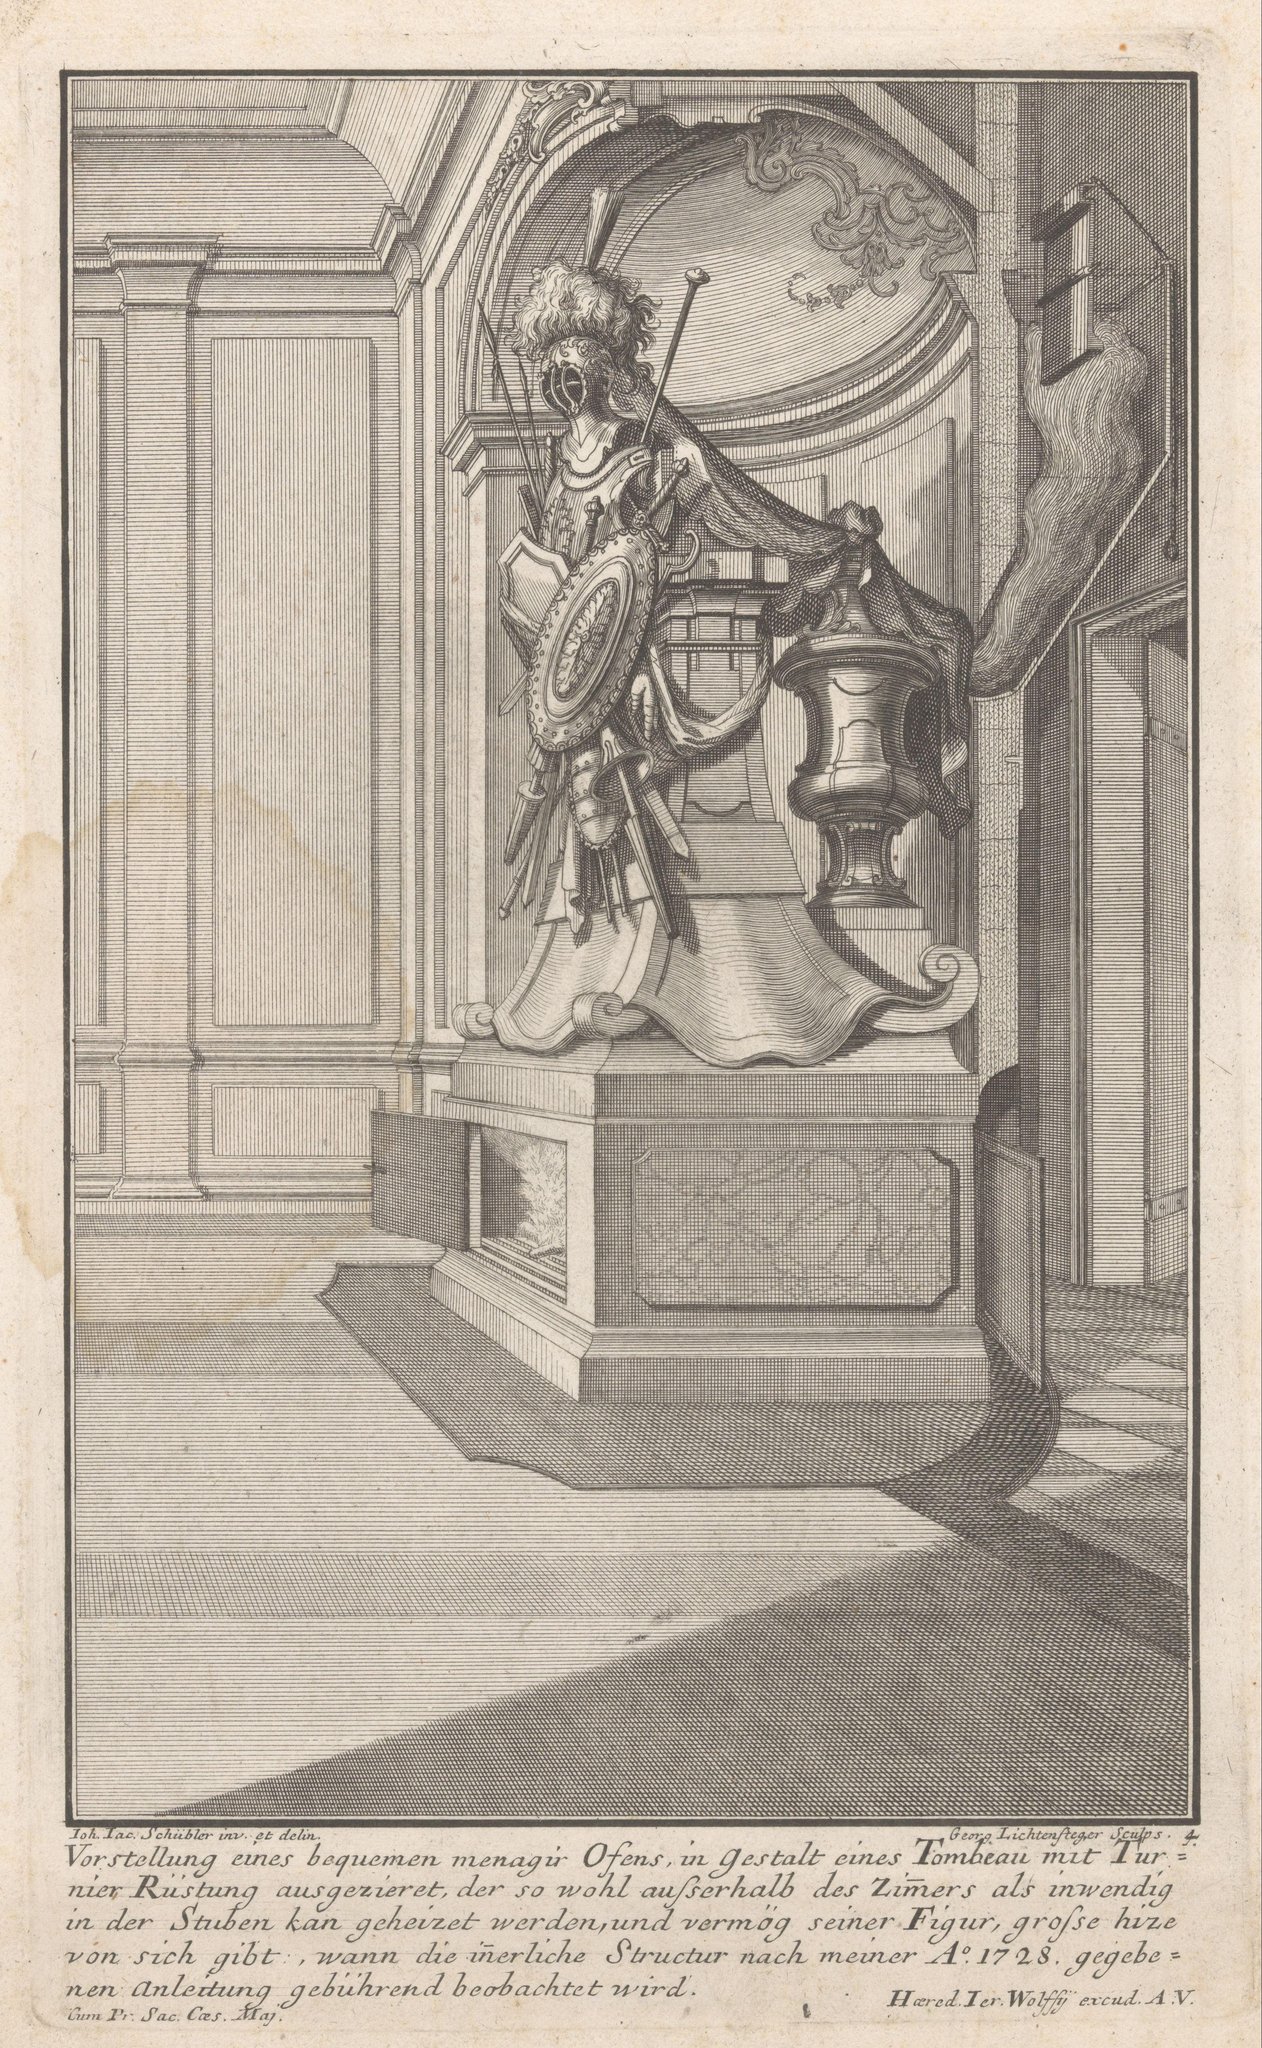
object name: ornament print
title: Schouw met wapens en harnas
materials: paper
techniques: engraving, etching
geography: augsburg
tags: protective weapons: shield, armour, open hearth, fire-place, weapons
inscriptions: collector's mark: Lugt 2228, collector's mark: Lugt 2760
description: Een geornamenteerde schouw met een harnas, een schild en wapens zoals lansen en zwaarden van rechts gezien. In de ondermarge een vijfregelige Duitse tekst.